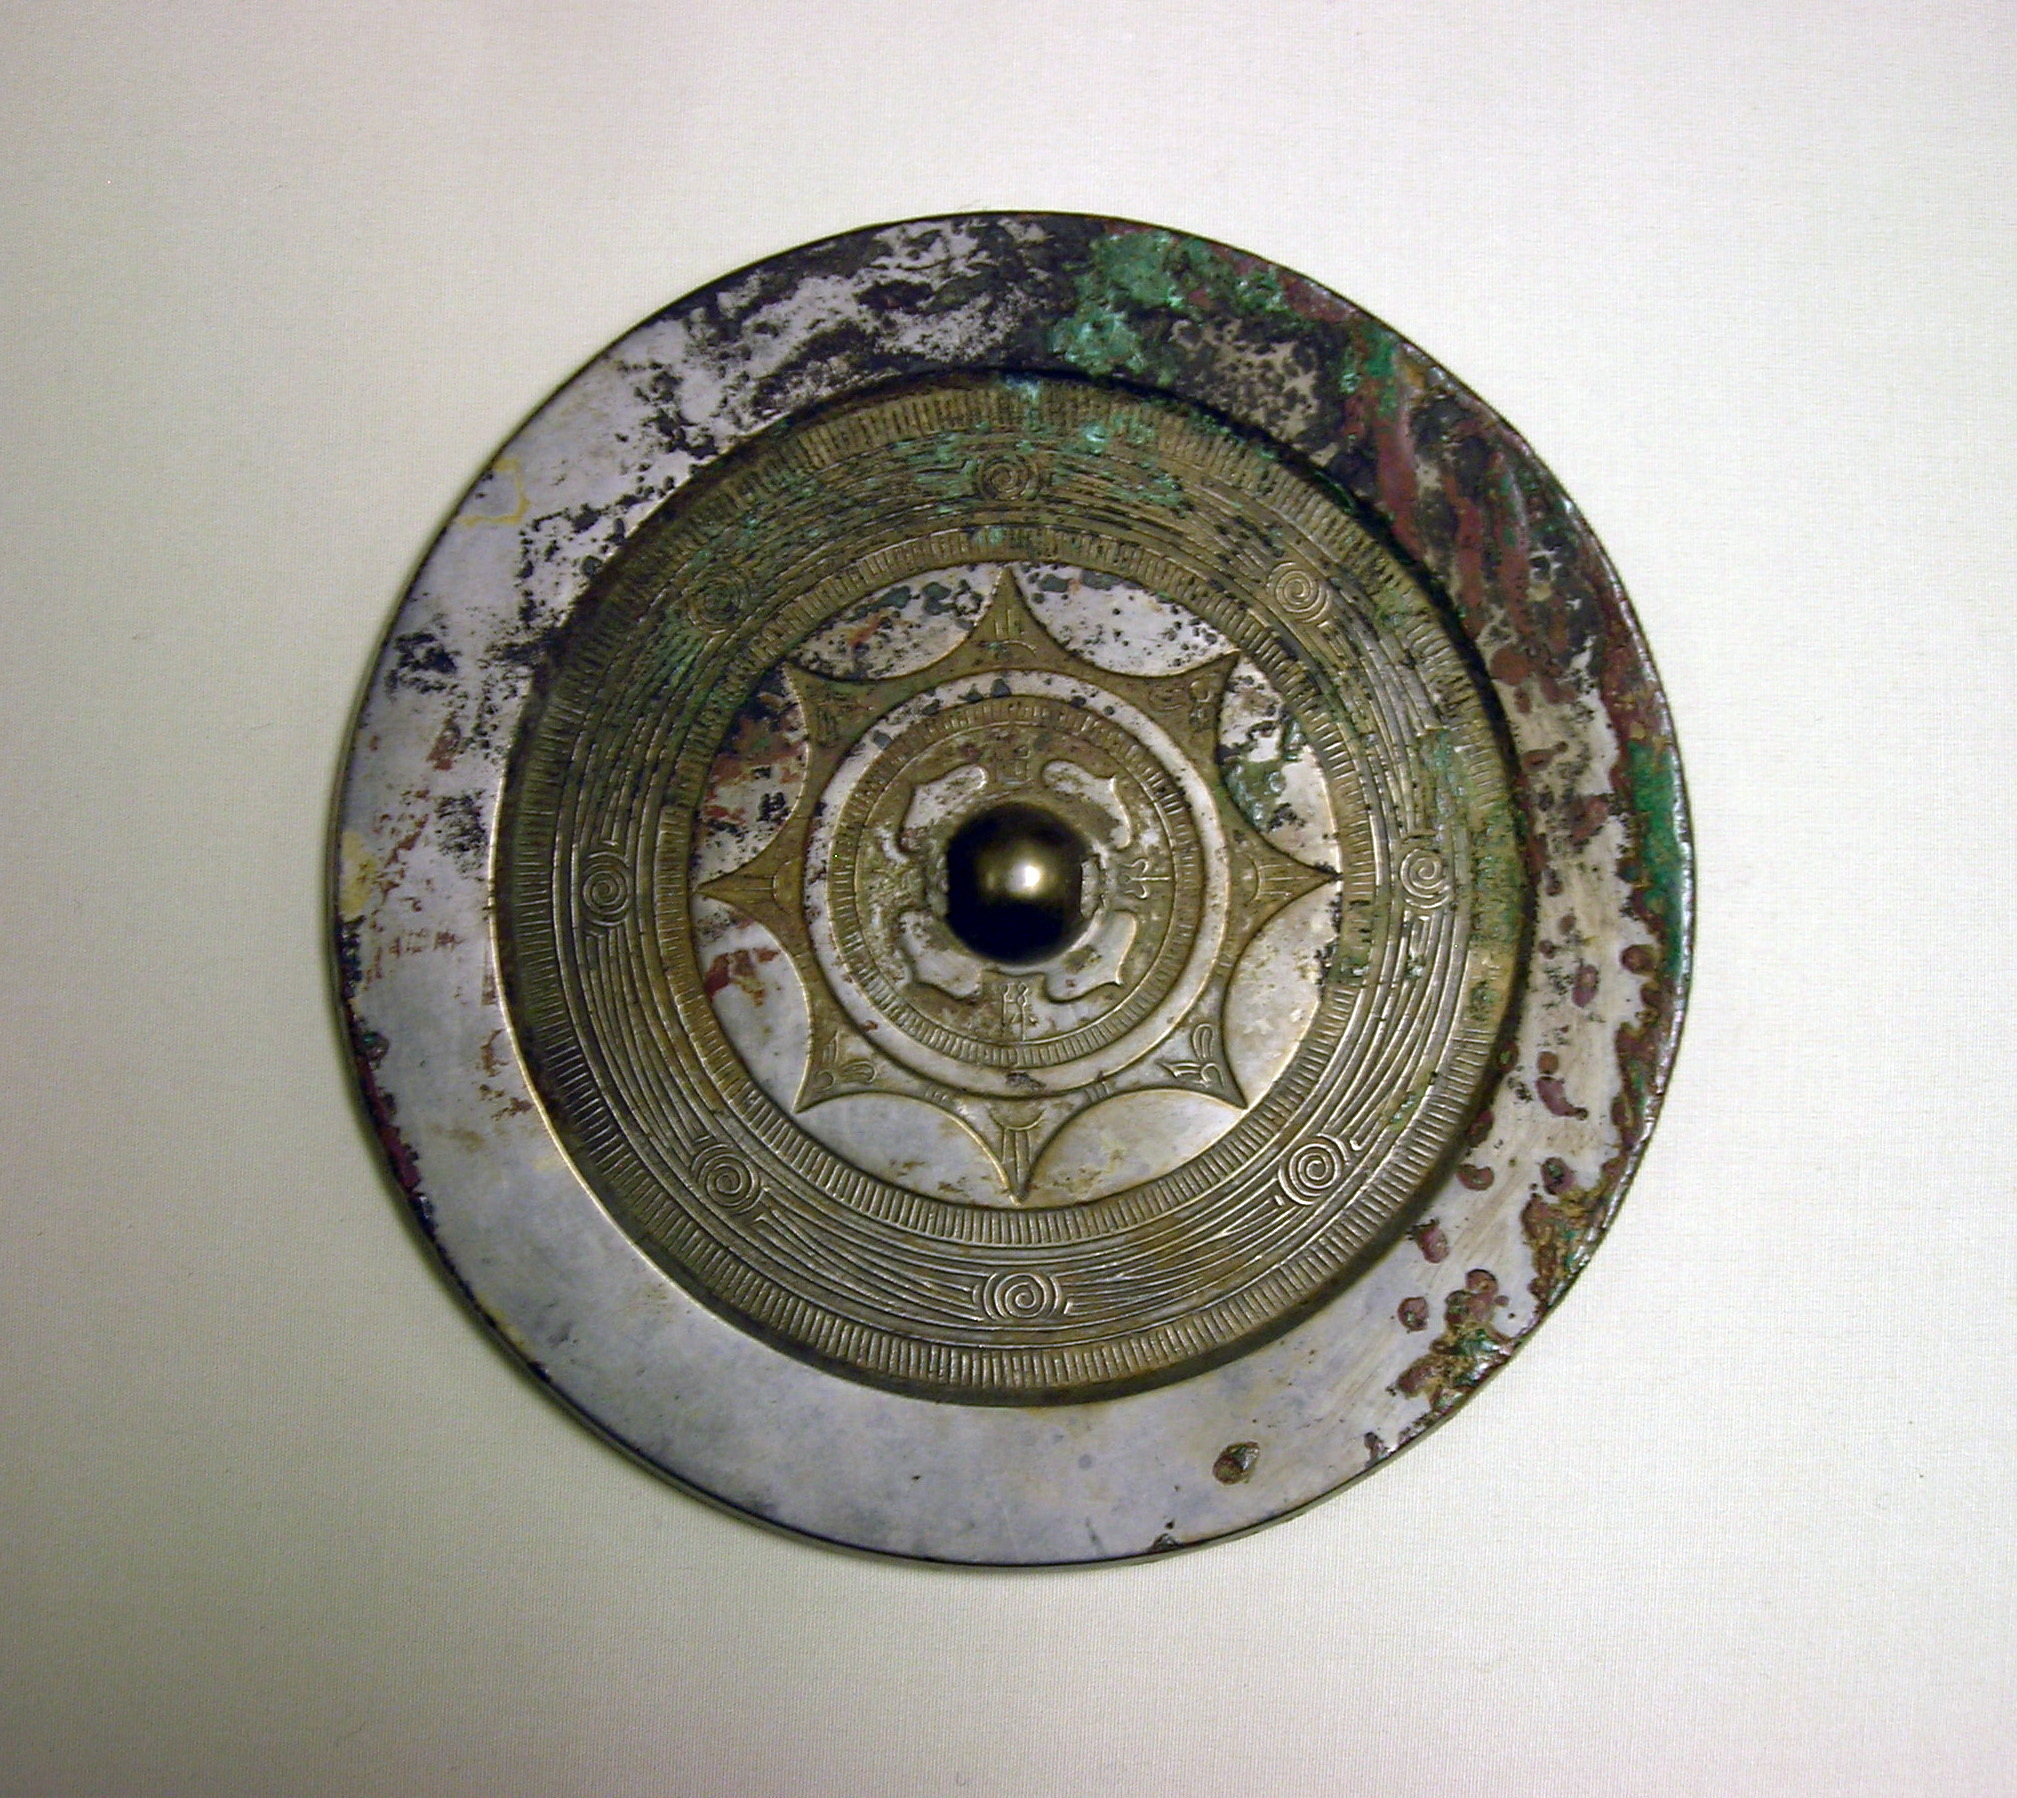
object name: mirror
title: Mirror with eight-point design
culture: chinese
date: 100-1 BCE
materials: bronze